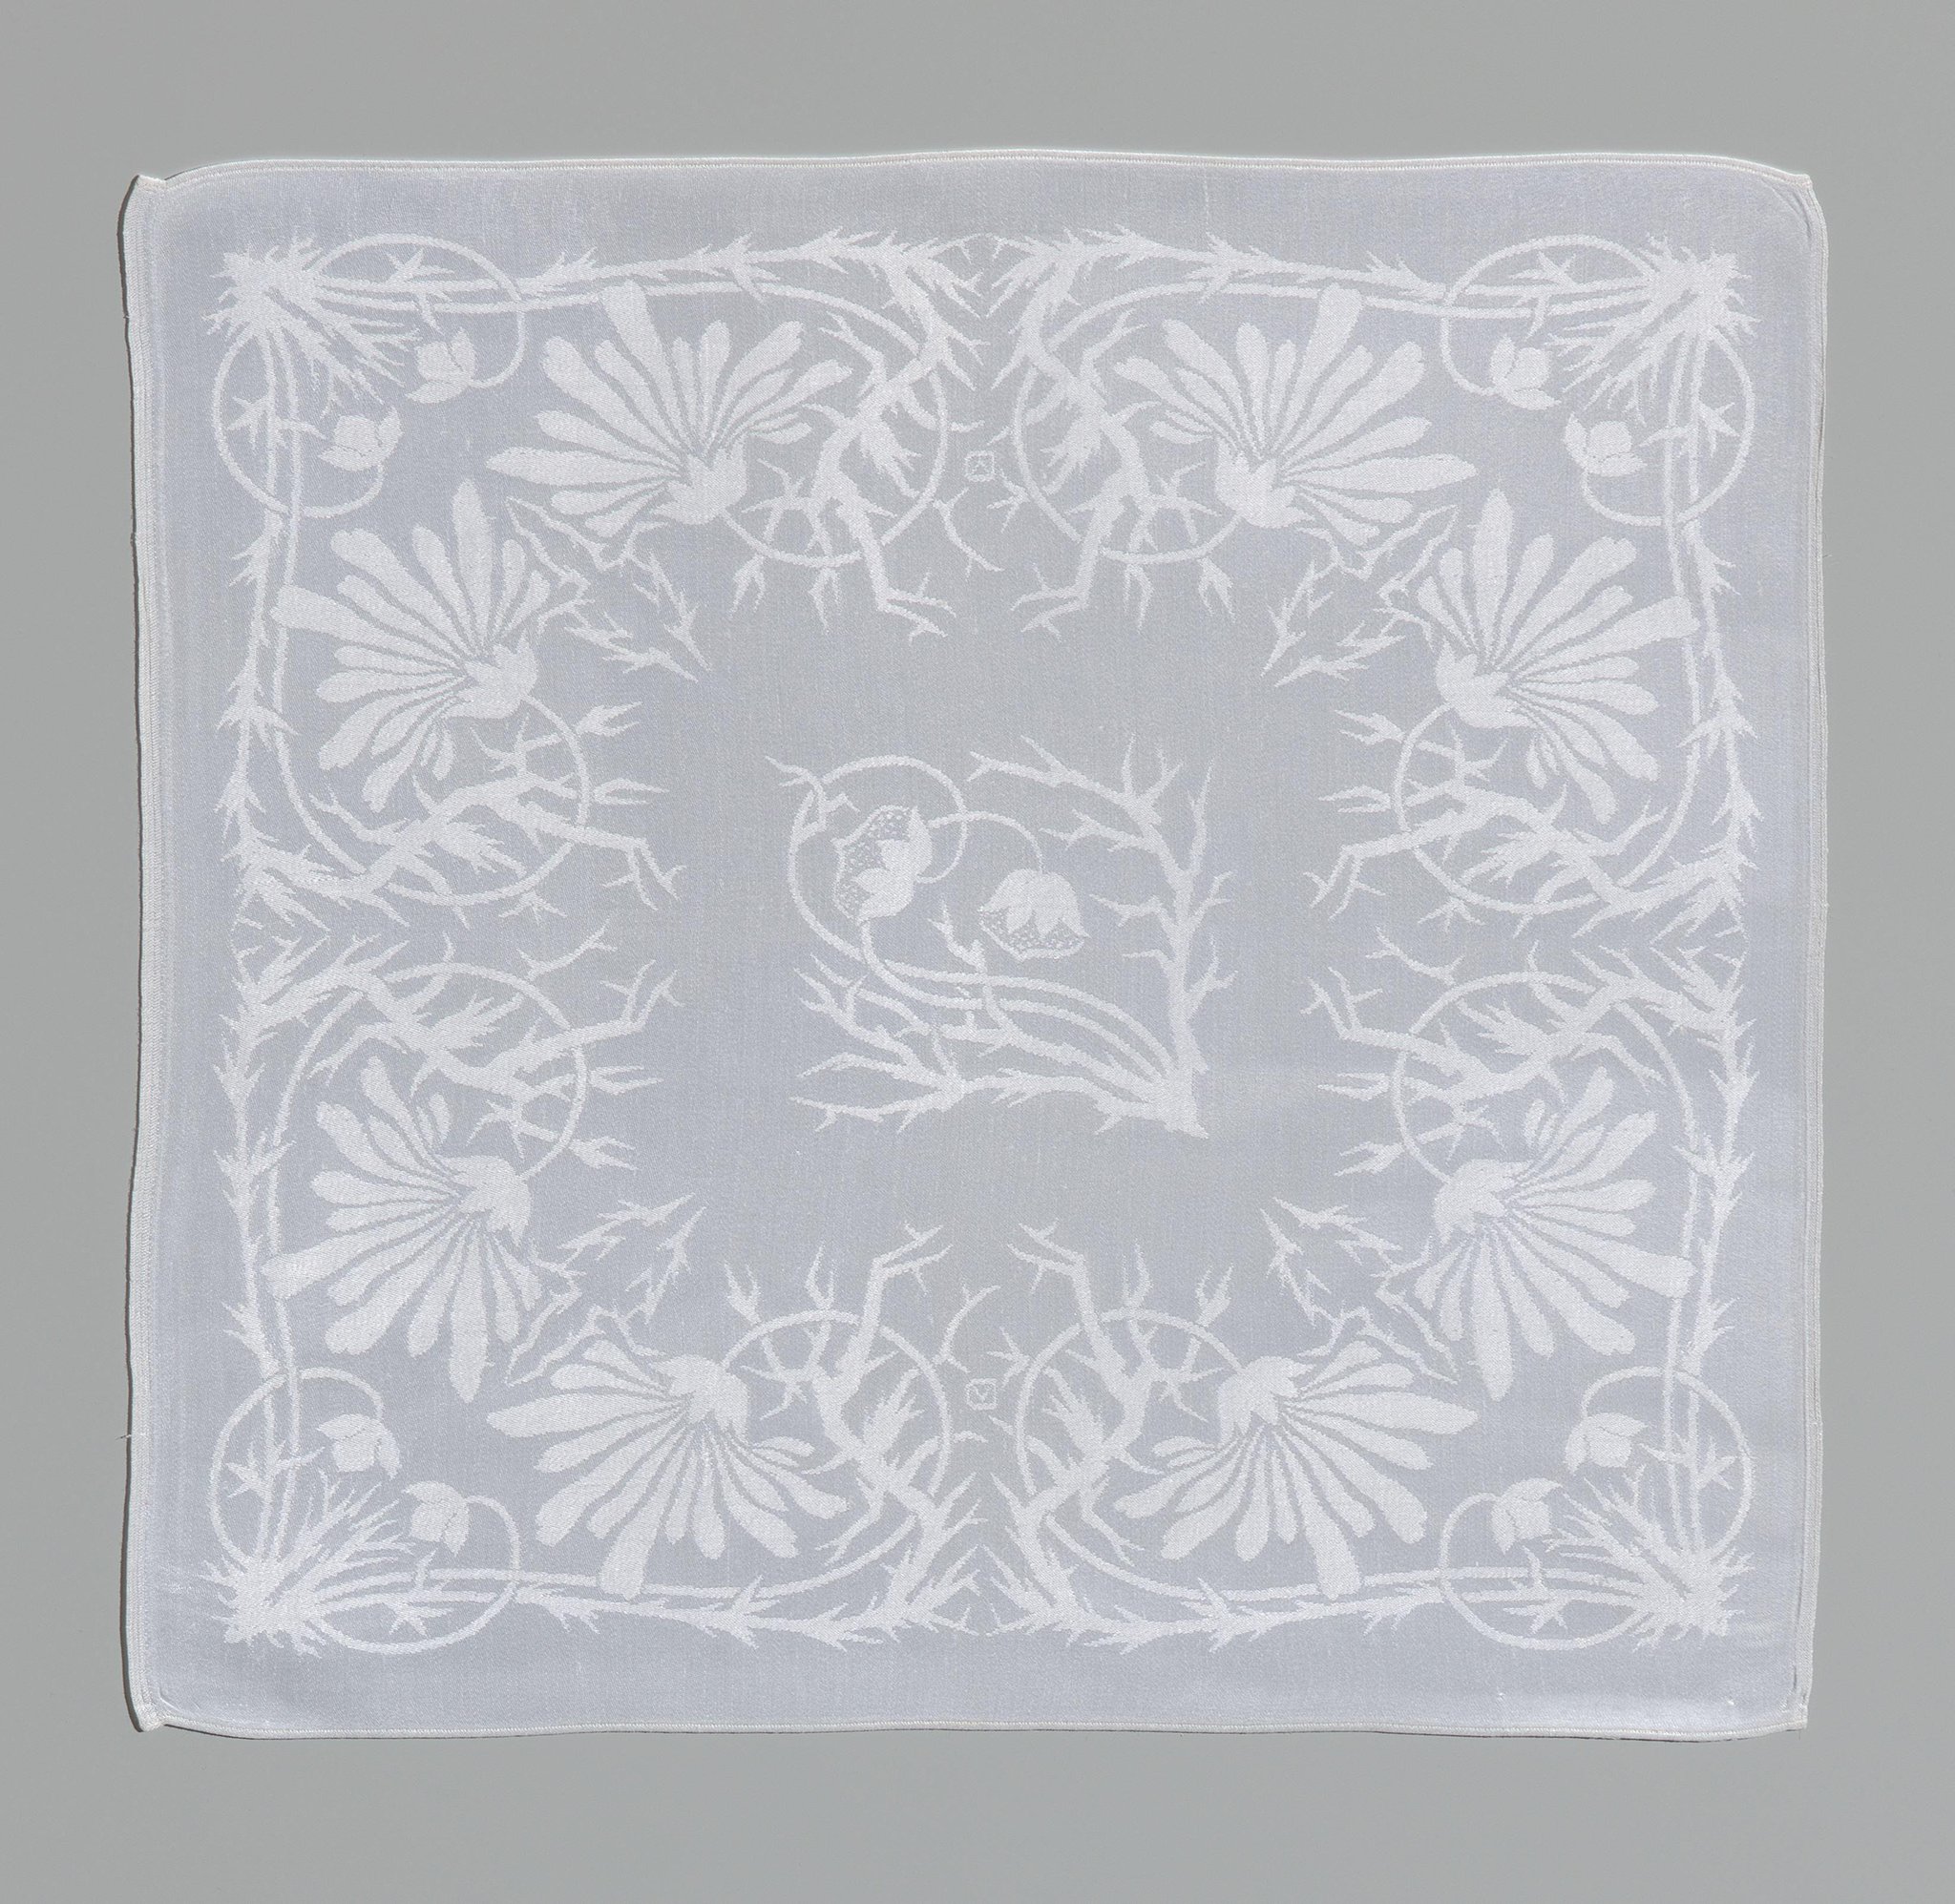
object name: vingerdoek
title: Vingerdoek van linnendamast met dessin Marguerite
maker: cornelis van der sluys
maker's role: print maker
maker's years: 1881-1944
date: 1904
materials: linen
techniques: damask, weave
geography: eindhoven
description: Vingerdoek van linnendamast met een bloempatroon: motief Marguerite, dessin nr. 500. De vingerdoek hoort bij elf vingerdoeken, dertien servetten en een tafellaken.